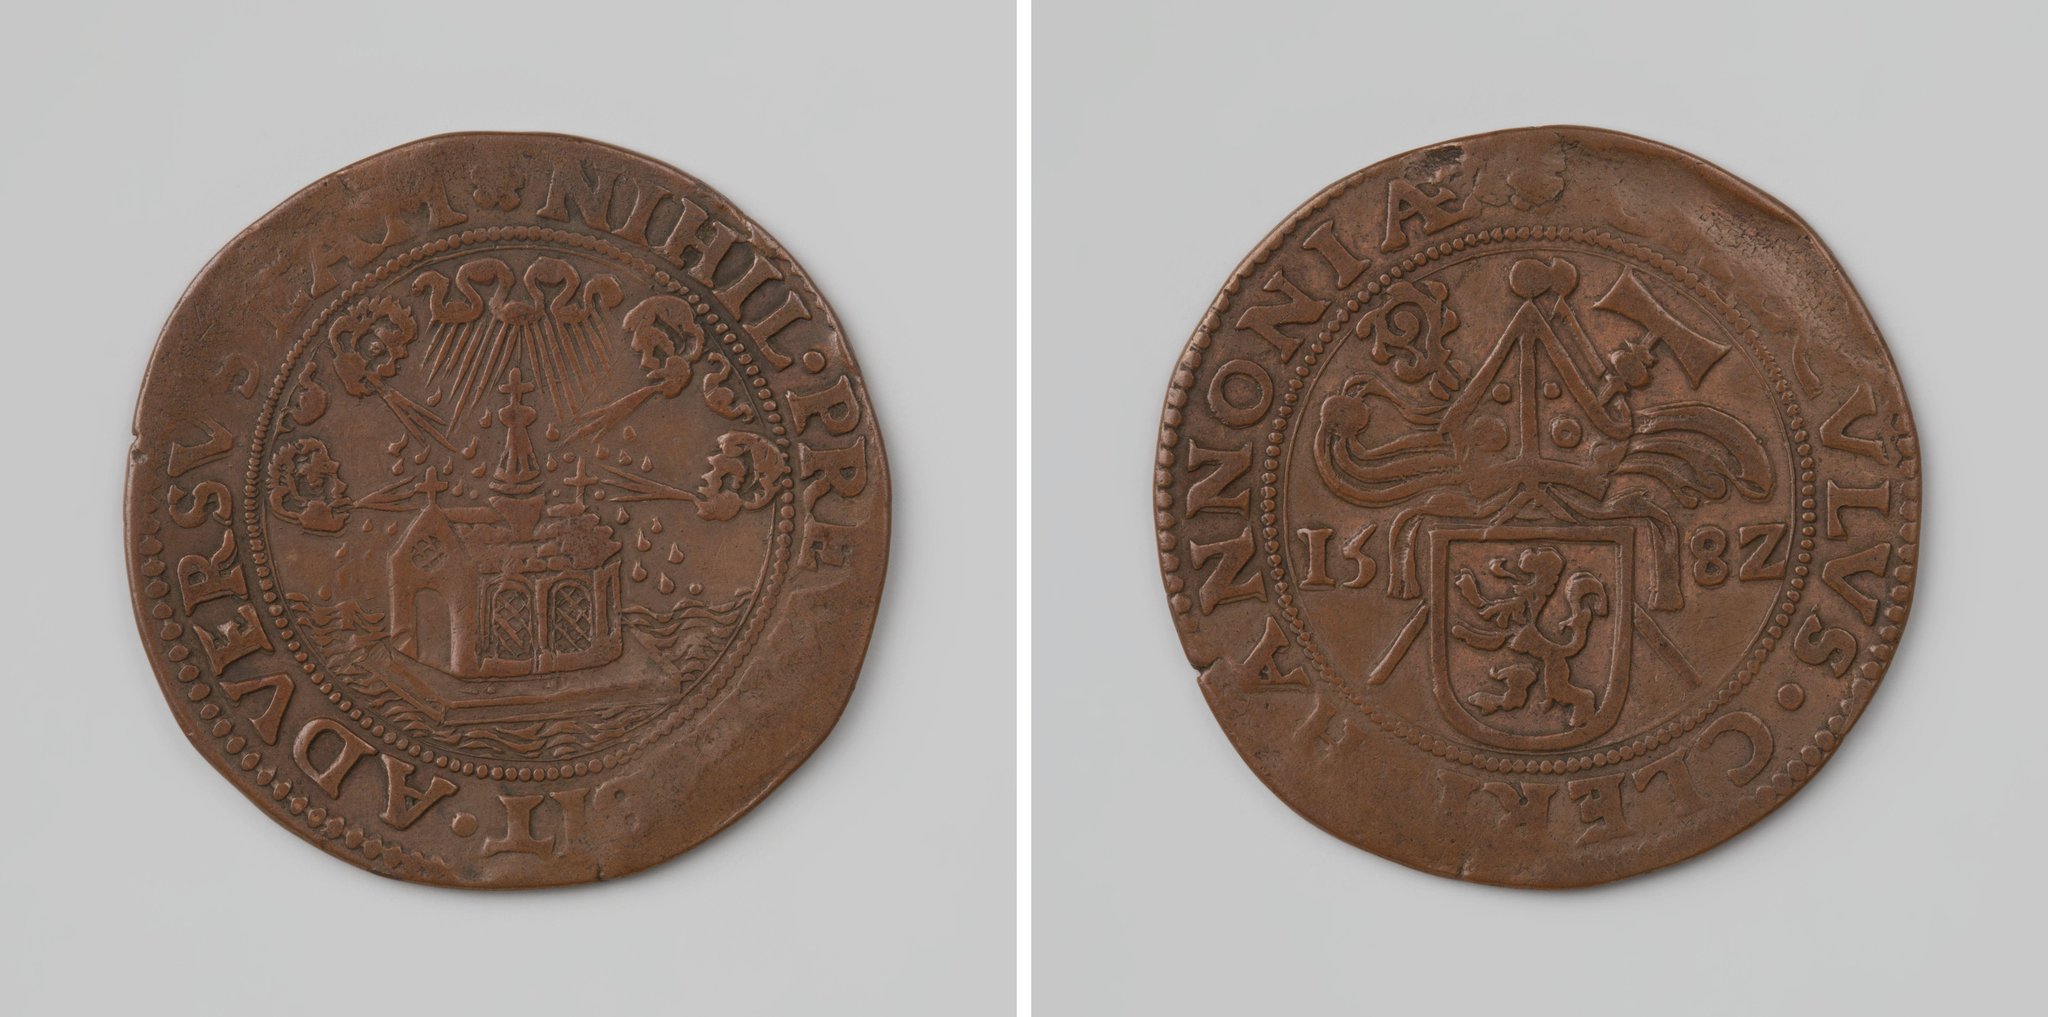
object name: jeton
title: Henegouwen houdt vast aan de rooms-katholieke godsdienst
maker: Anonymous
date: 1582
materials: copper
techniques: striking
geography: belgium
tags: graafschap henegouwen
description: Koperen penning. Voorzijde: kerk, die door stormen geteisterd wordt binnen omschrift. Keerzijde: wapenschild onder mijter, op gekruiste staf en hark [?] tussen jaartal binnen omschrift